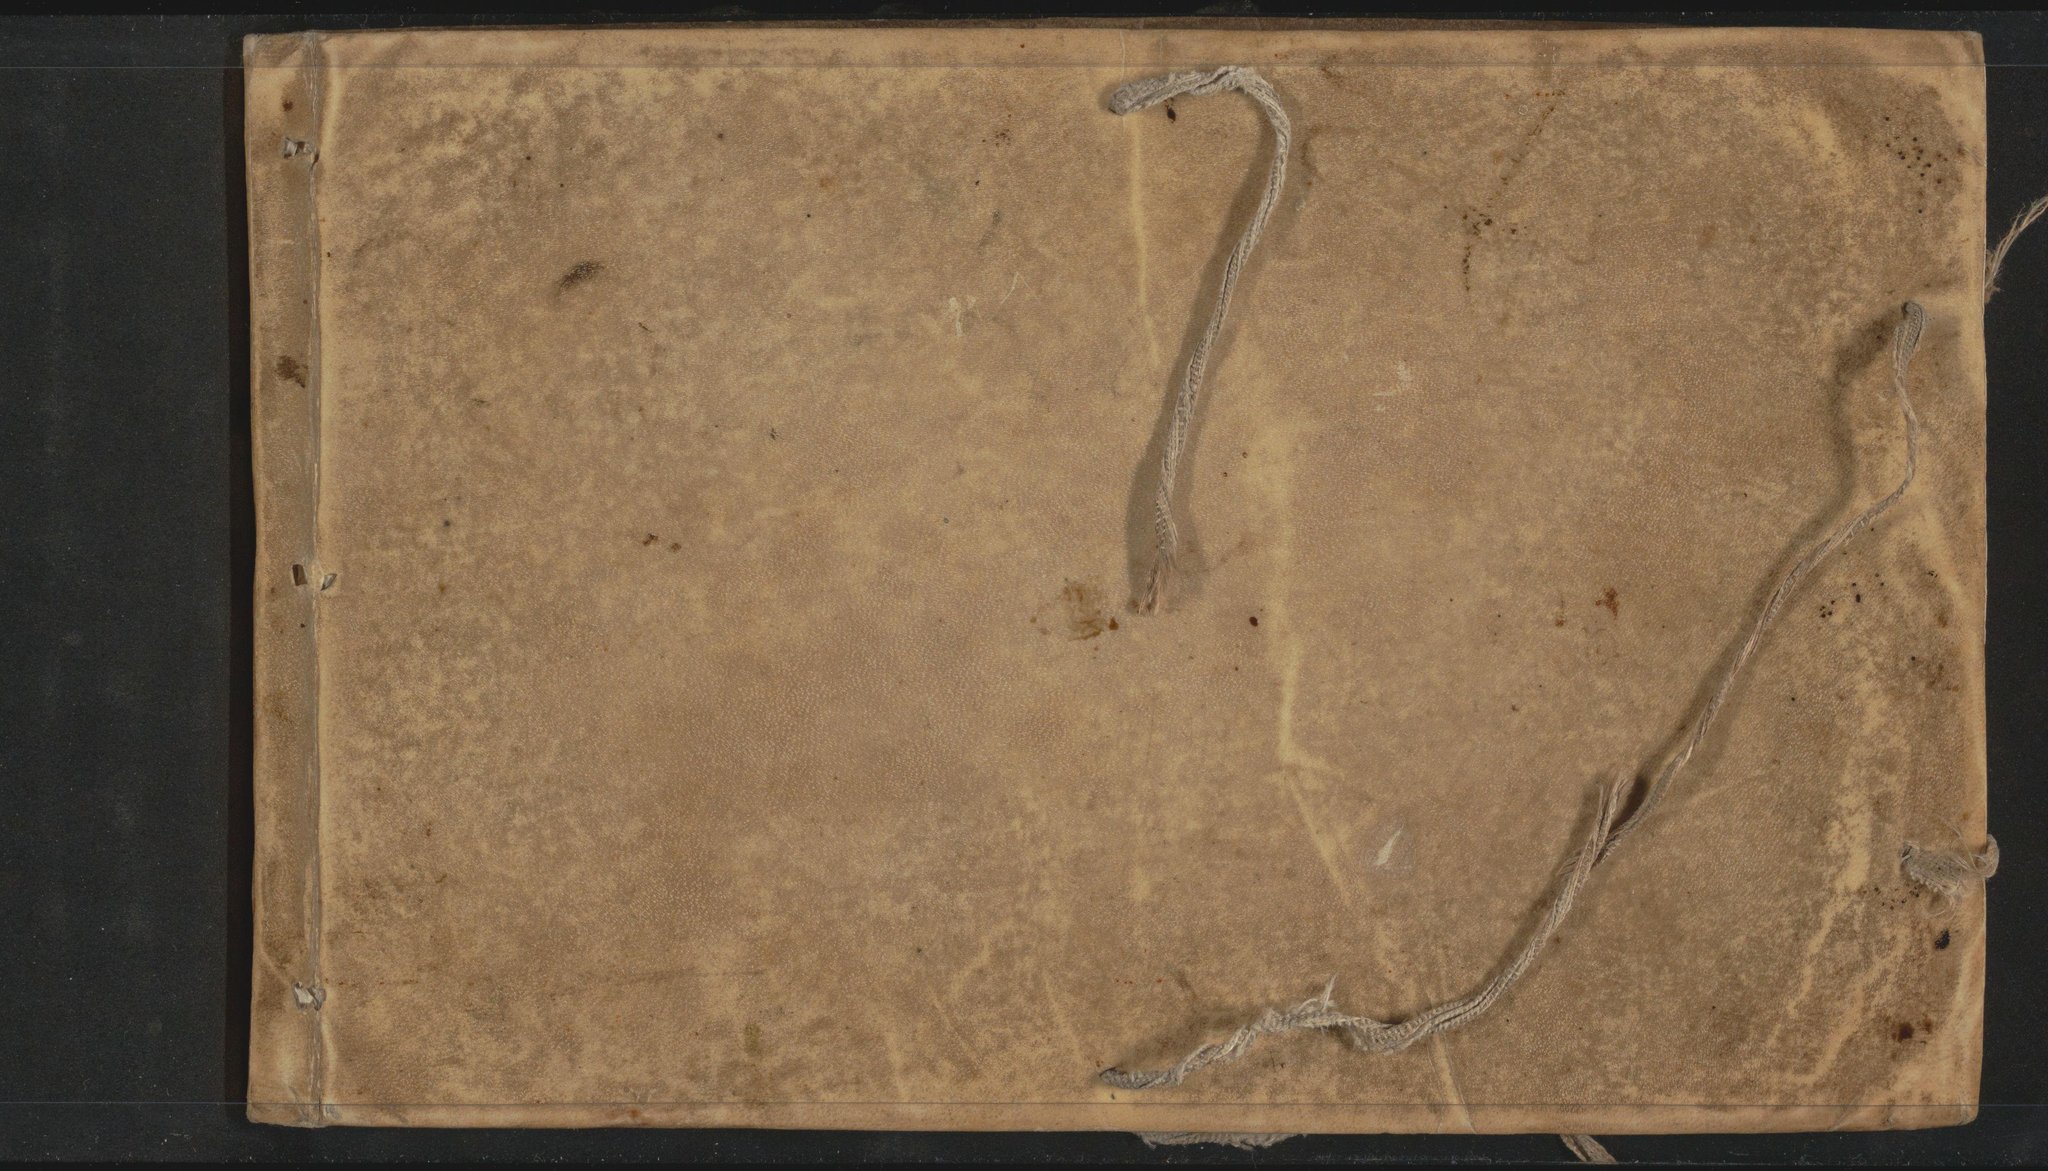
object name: sketchbook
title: Schetsboek met 39 bladen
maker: pieter moninckx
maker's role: draughtsman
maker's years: 1606-1686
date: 1645-1646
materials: chalk, linen, paper, parchment, pencil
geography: the hague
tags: prospect of village, silhouette of village, landscapes (+ landscape with figures, staffage), farm or solitary house in landscape, the hague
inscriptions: collector's mark: Lugt 2228a, date and inscription: ‘Teekeningen van Sr. Pieter Monincx./ gedaen ontrent den jaere 1645/ & 1646 [...]’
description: Schetsboek bestaande uit 39 bladen met landschappen, bosgezichten, stadsgezichten en boerderijen.